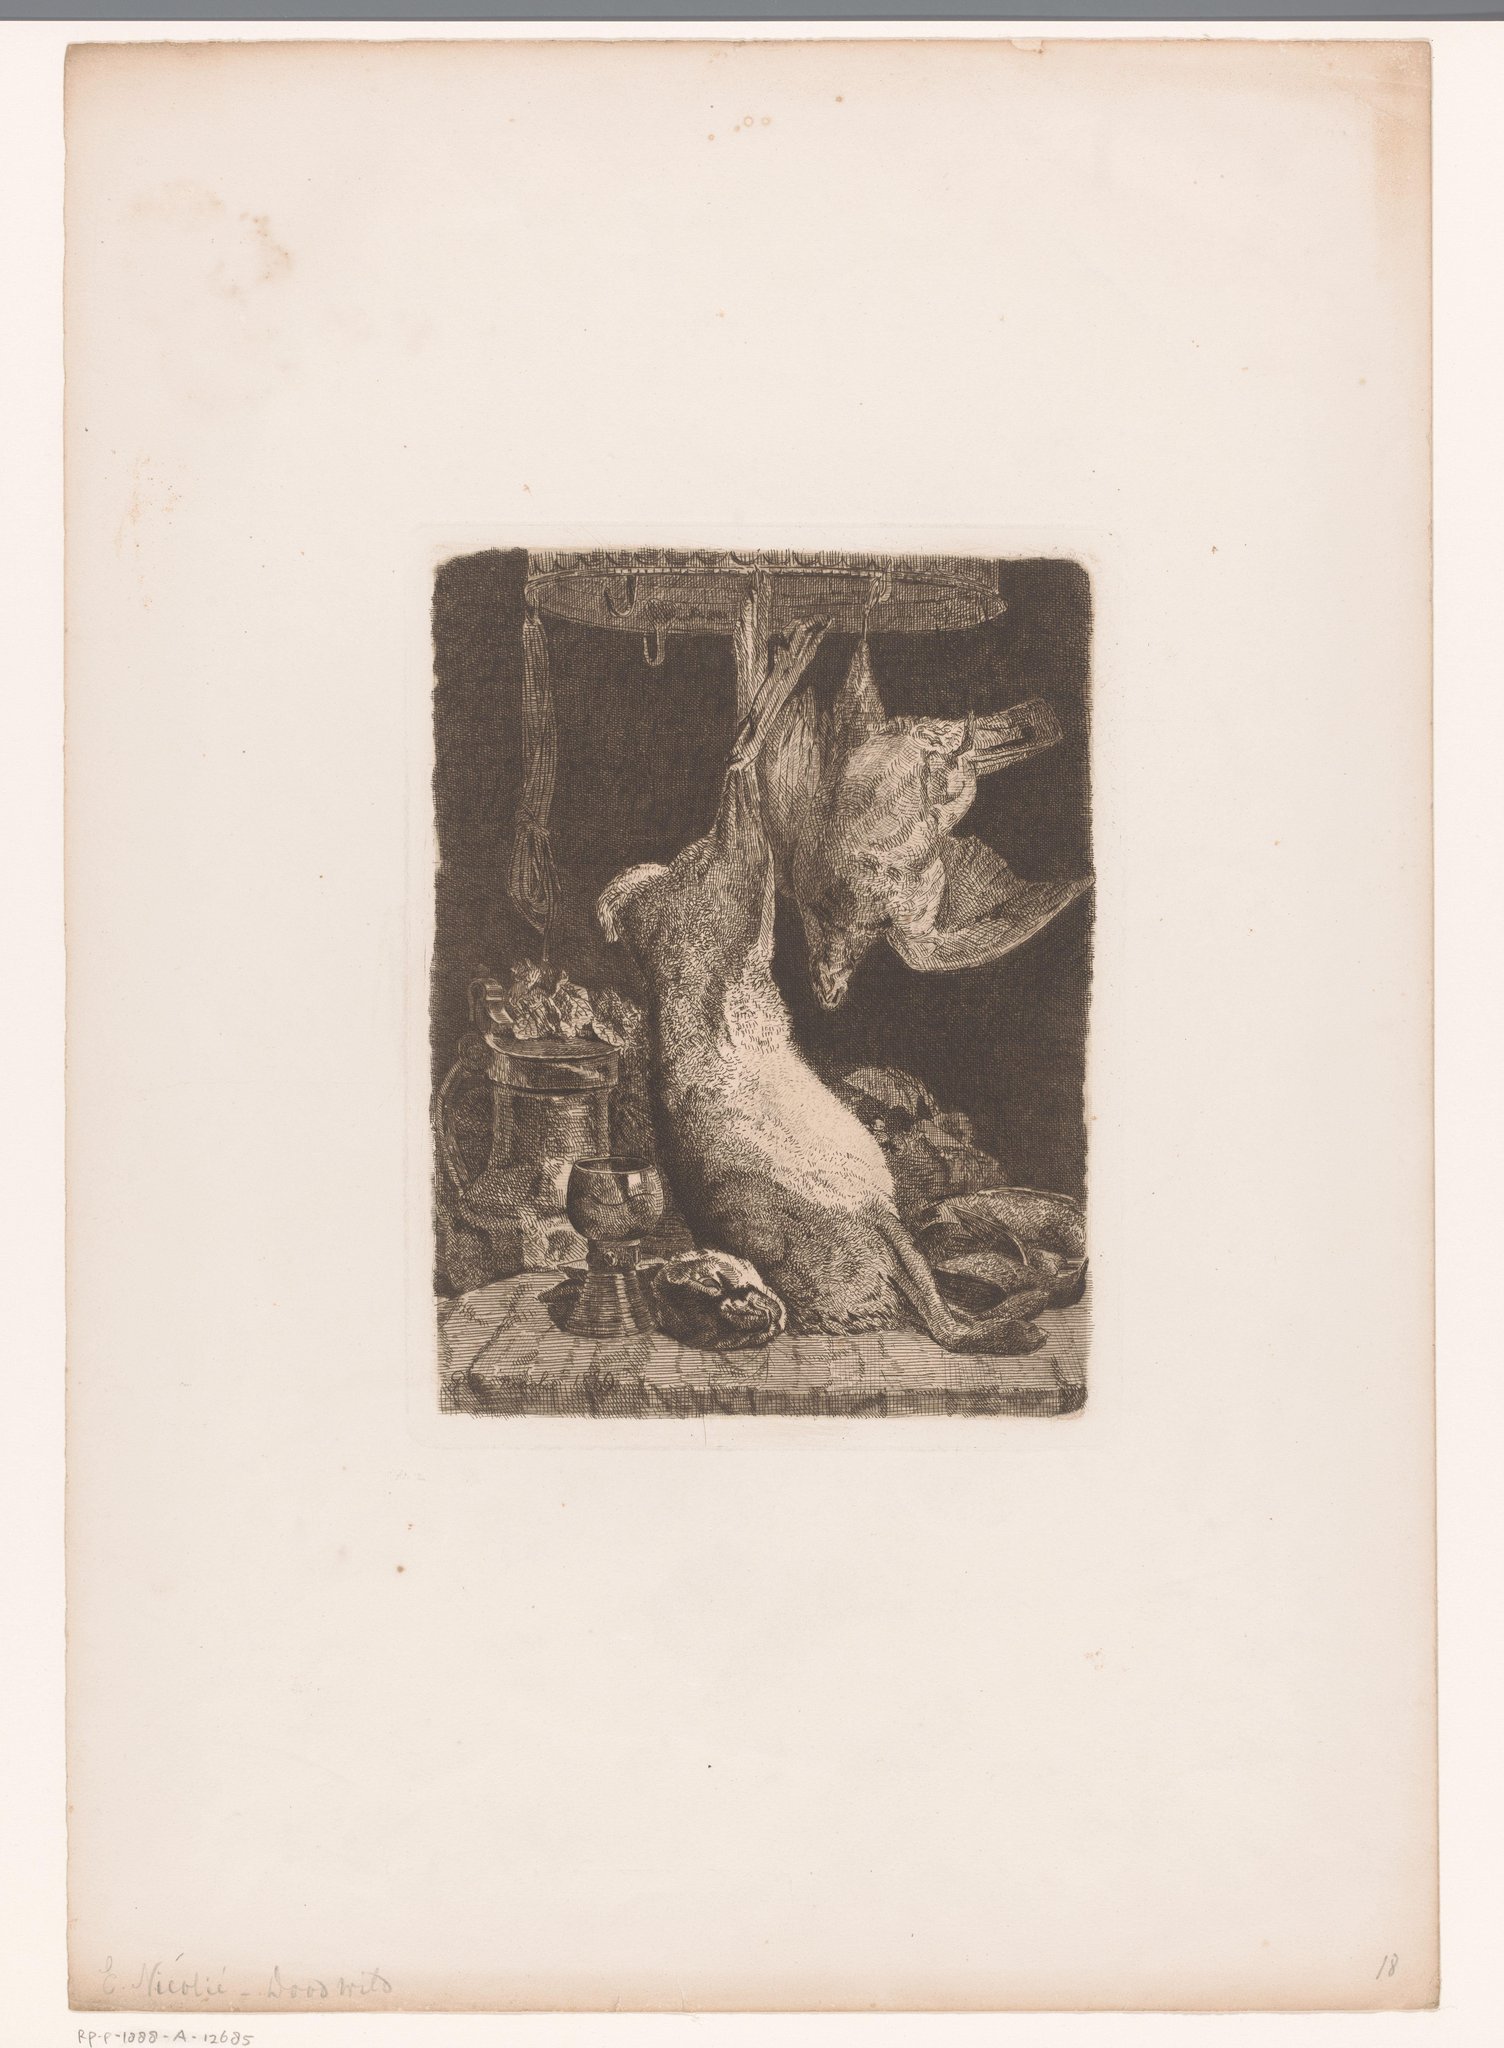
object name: print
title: Stilleven met een haas en patrijs aan een wildkroon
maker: paul emile nicolié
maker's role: print maker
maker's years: 1828-1894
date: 1880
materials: paper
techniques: etching, intaglio, roulette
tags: rodents: hare, walker and runner birds: partridge, hunting trophies, foodstuffs; still life of foodstuffs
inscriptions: collector's mark: Lugt 2228